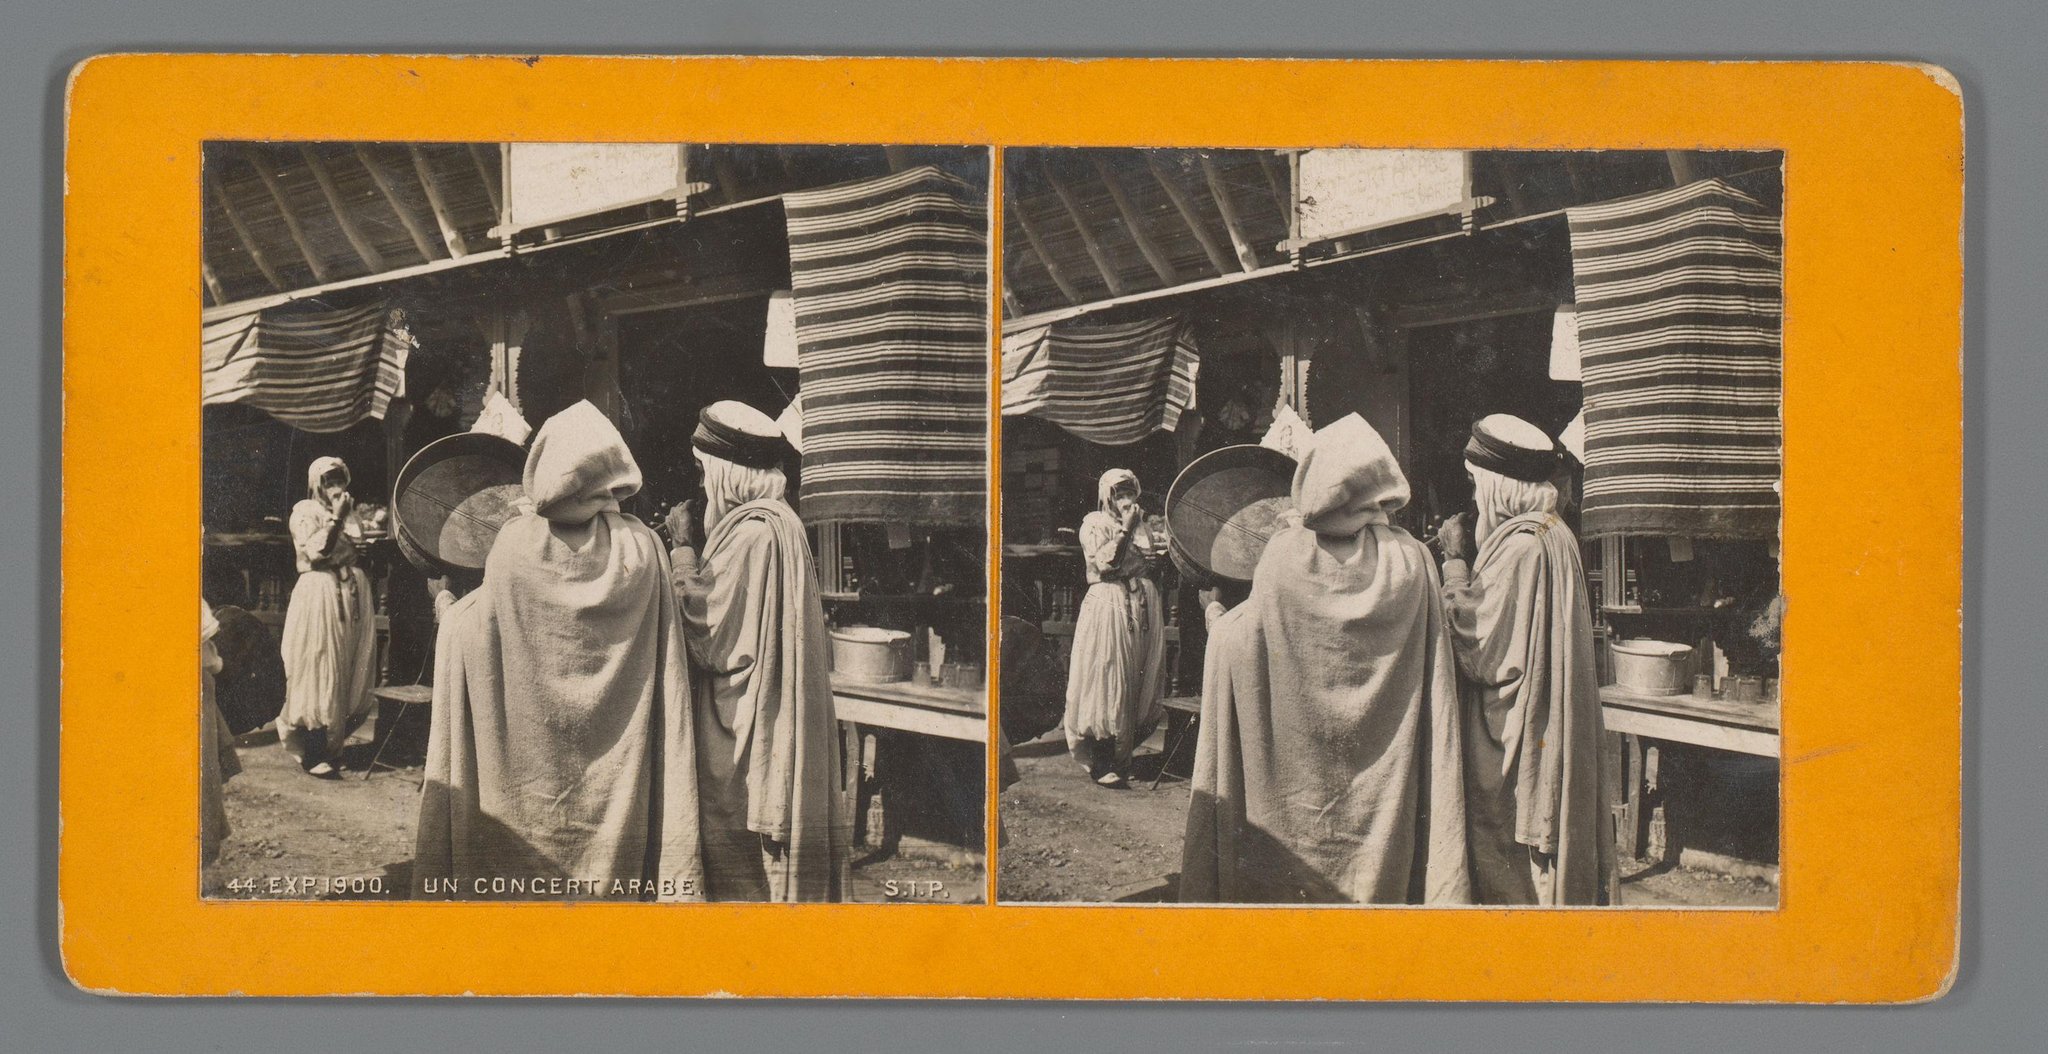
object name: stereograph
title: Straatartiesten uit het Midden-Oosten tijdens de Wereldtentoonstelling van 1900 in Parijs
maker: Anonymous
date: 1900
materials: paper, cardboard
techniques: gelatin silver print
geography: paris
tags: performance, paris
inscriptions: number: ‘44.’